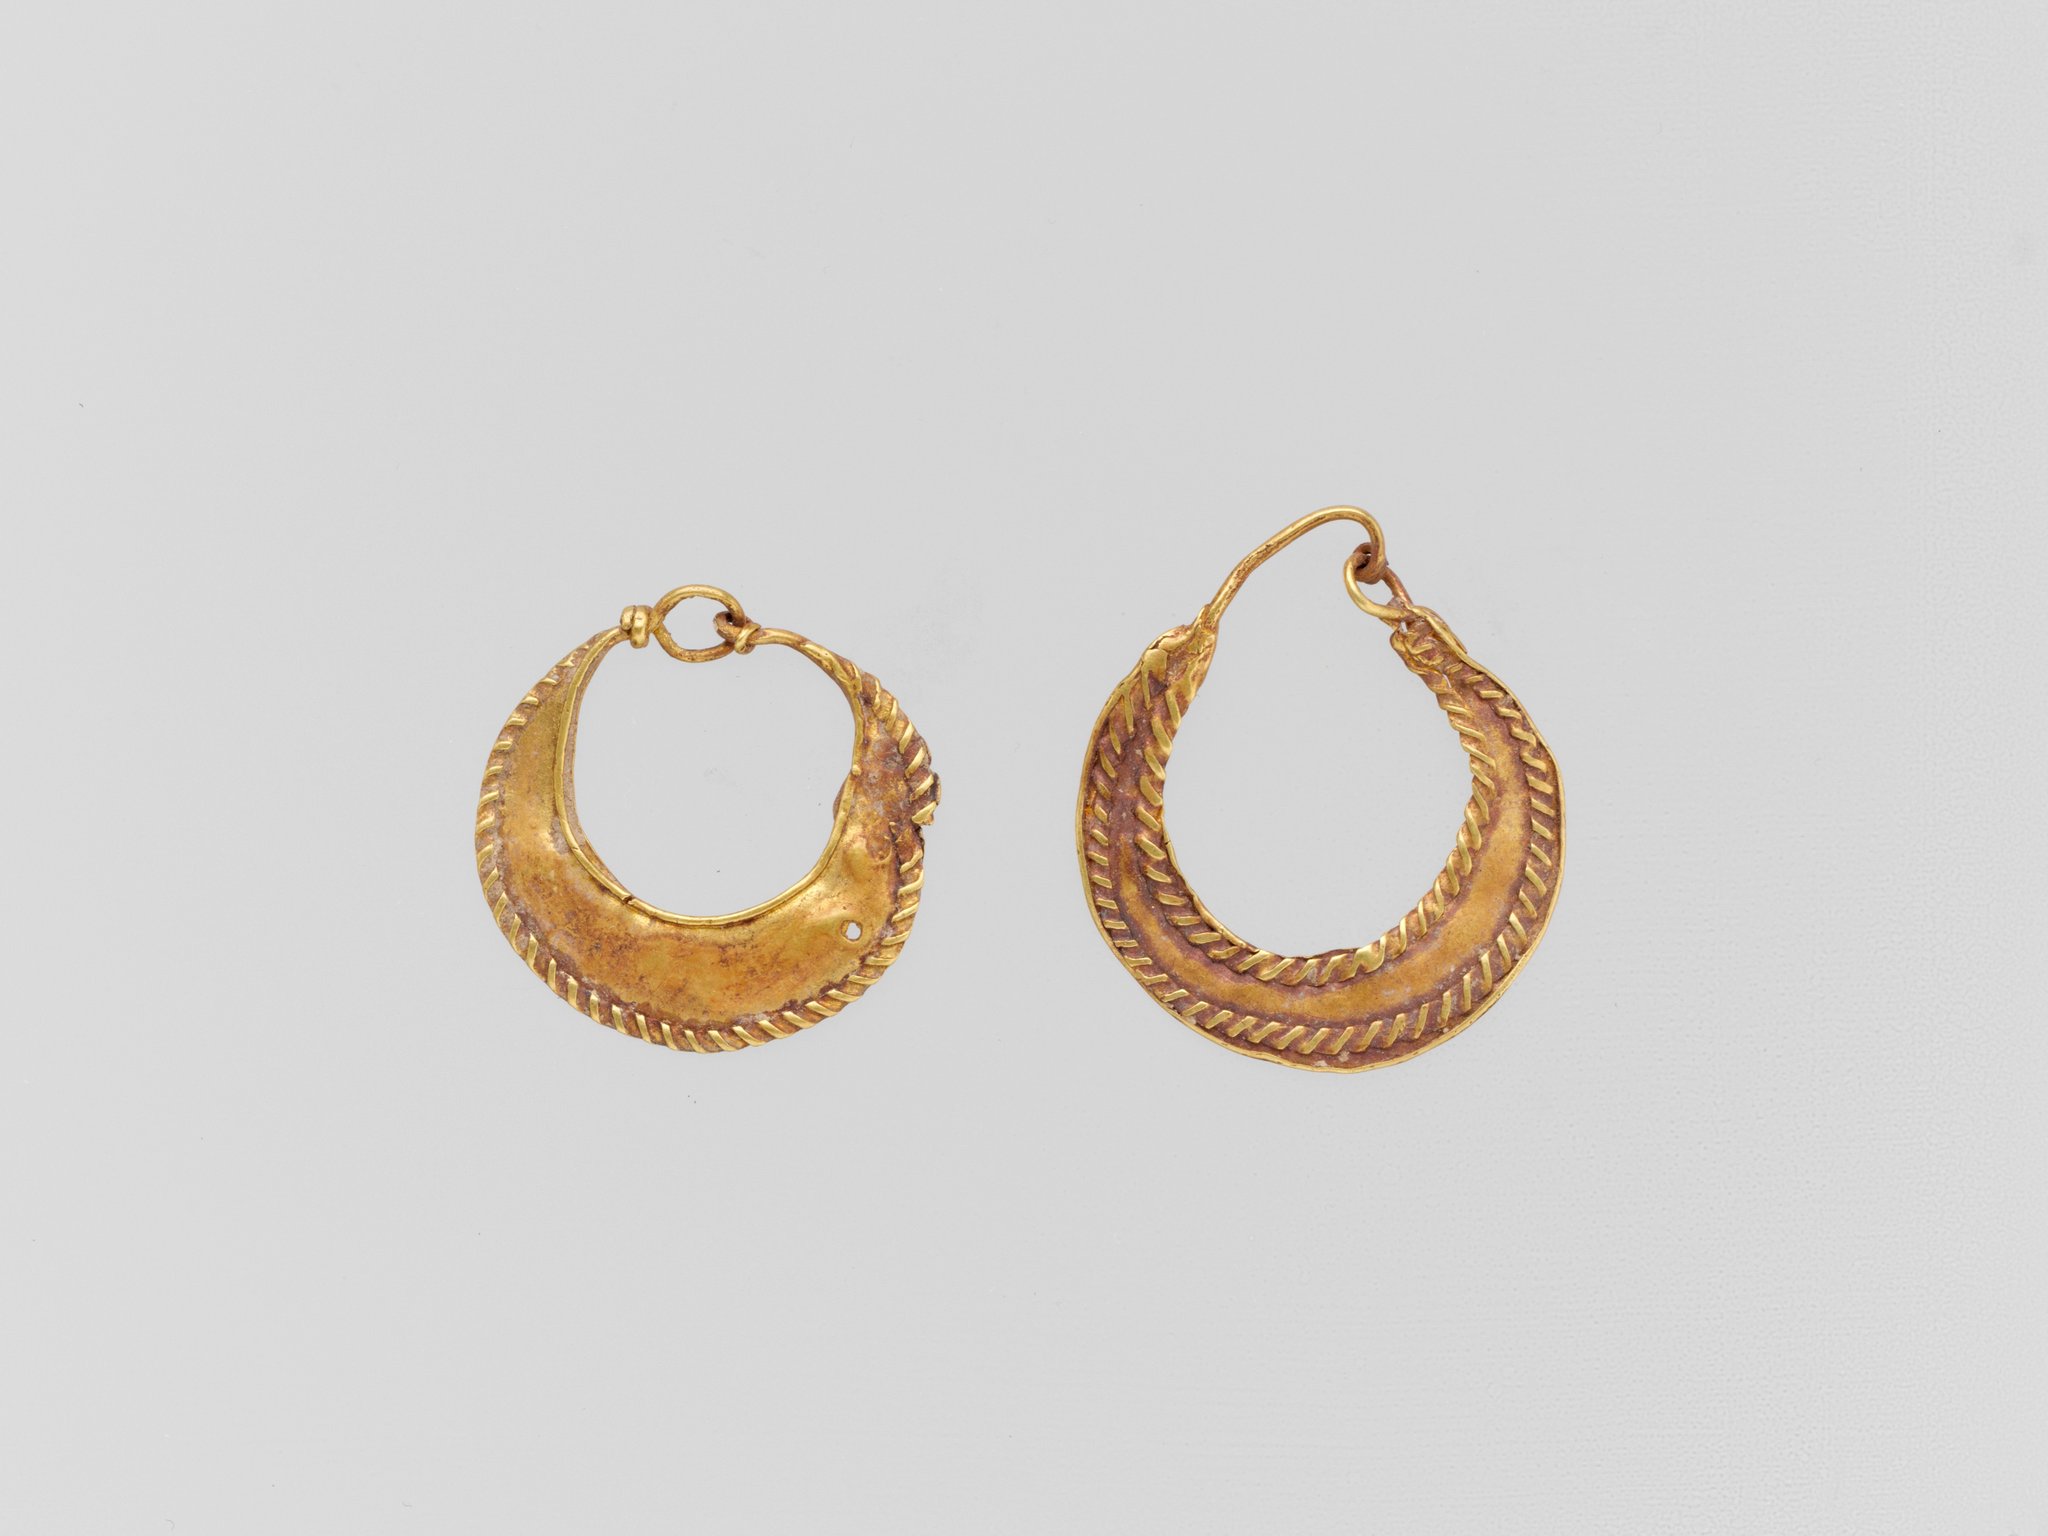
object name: earring, crescent shaped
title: Gold crescent-shaped earring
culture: cypriot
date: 500 BCE-100 CE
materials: gold